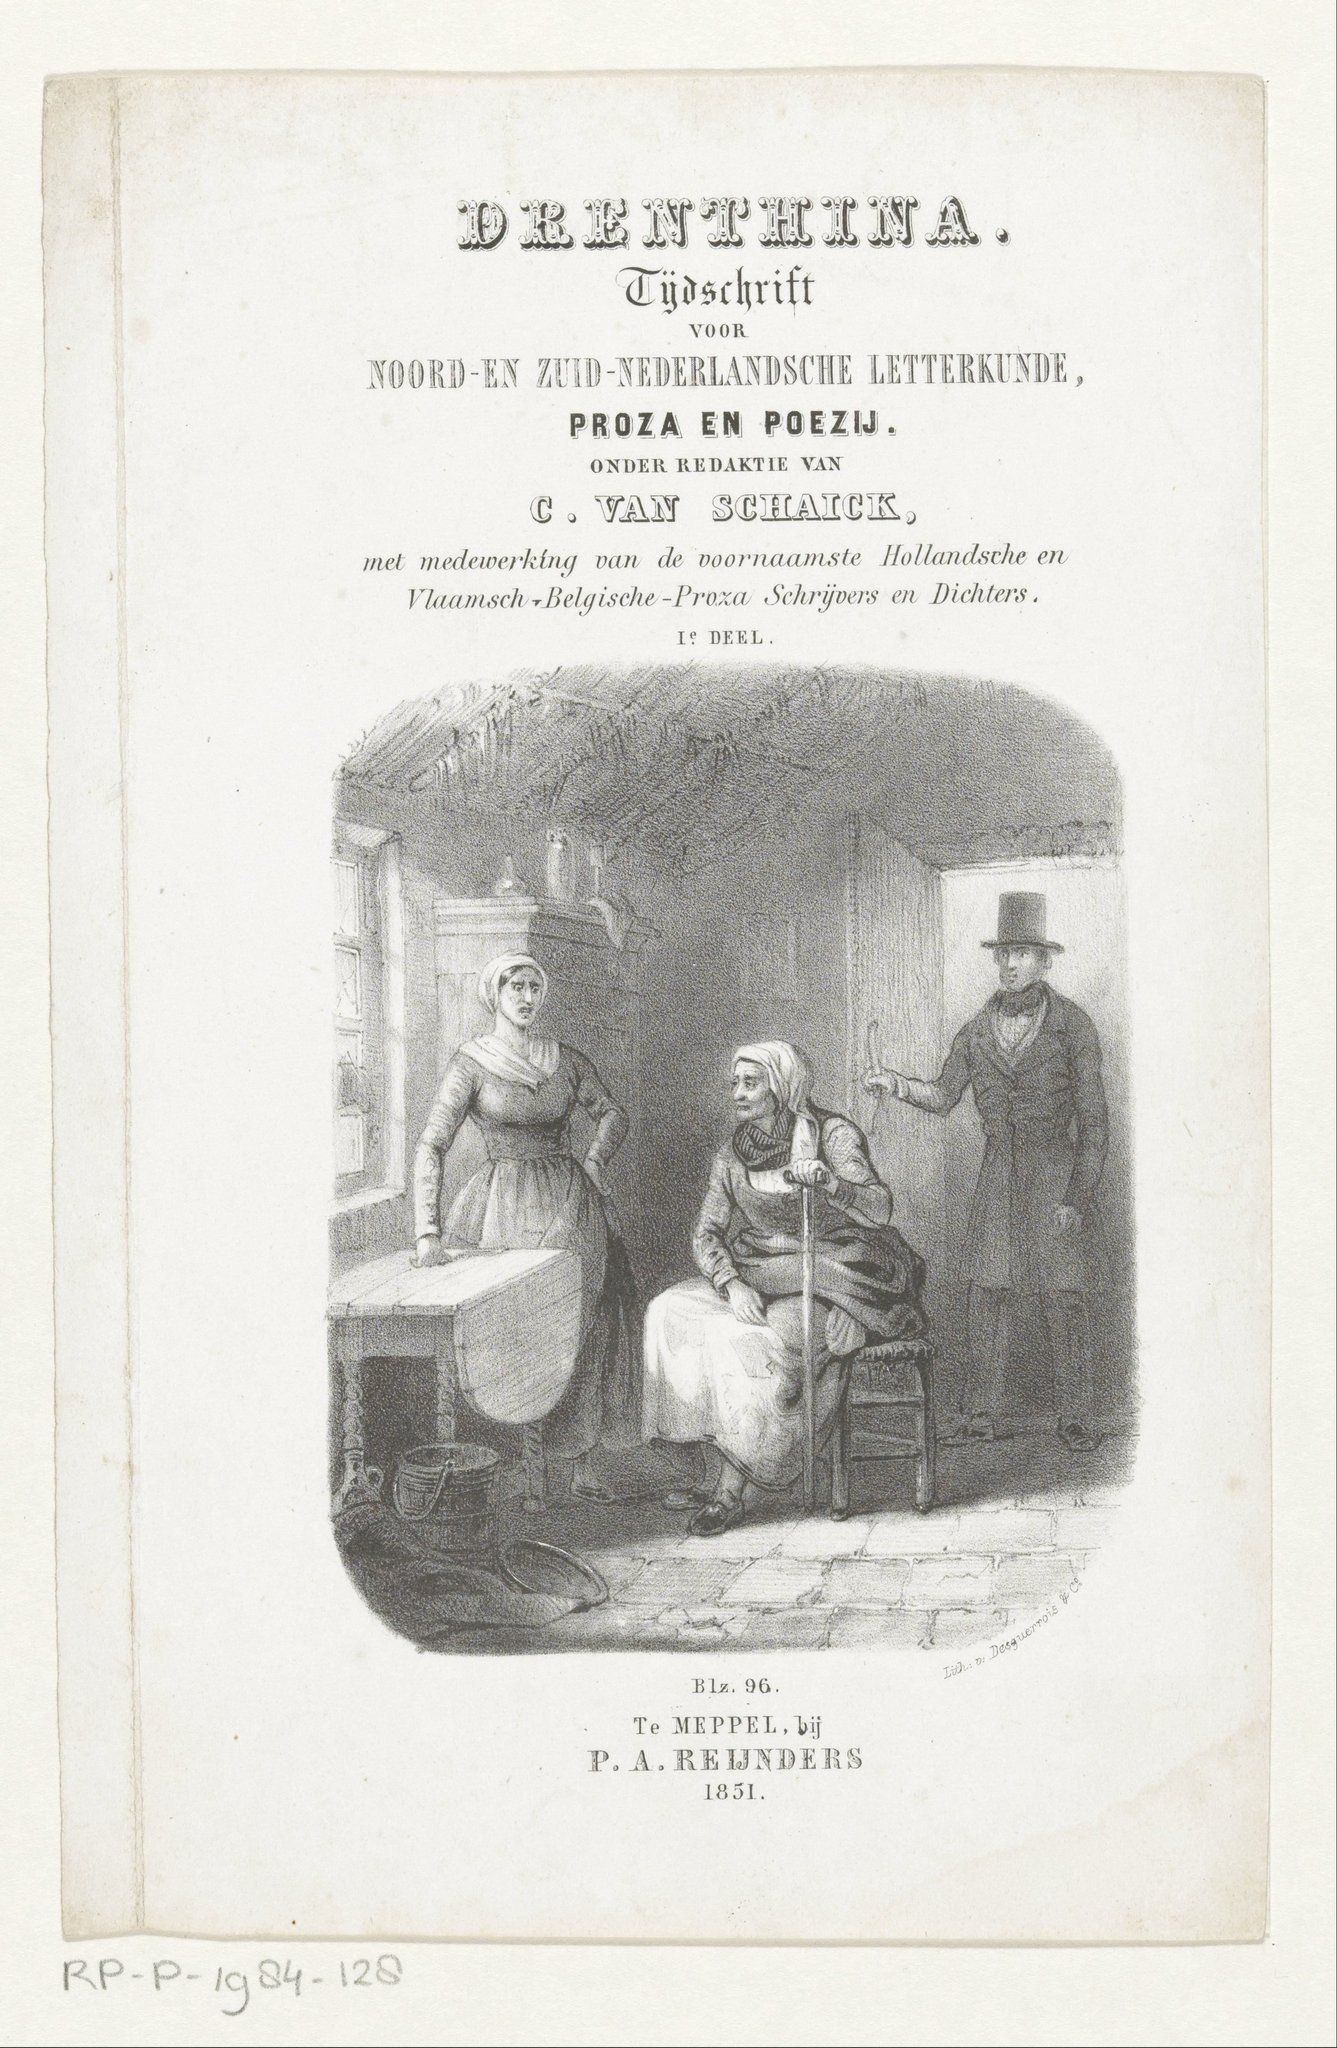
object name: print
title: Titelpagina voor: C. van Schaik, Drenthina, 1851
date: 1851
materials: paper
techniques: lithograph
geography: meppel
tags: opening the door, conversation, dialogue; conversation piece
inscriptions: collector's mark: Lugt 2760, collector's mark: Lugt 2228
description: Twee armoedig geklede vrouwen zijn in gesprek. De oudere van de twee zit met stok op een kruk. Rechts komt een chiquer geklede man met hoge hoed, de zoon van de oude vrouw, de ruimte binnen.